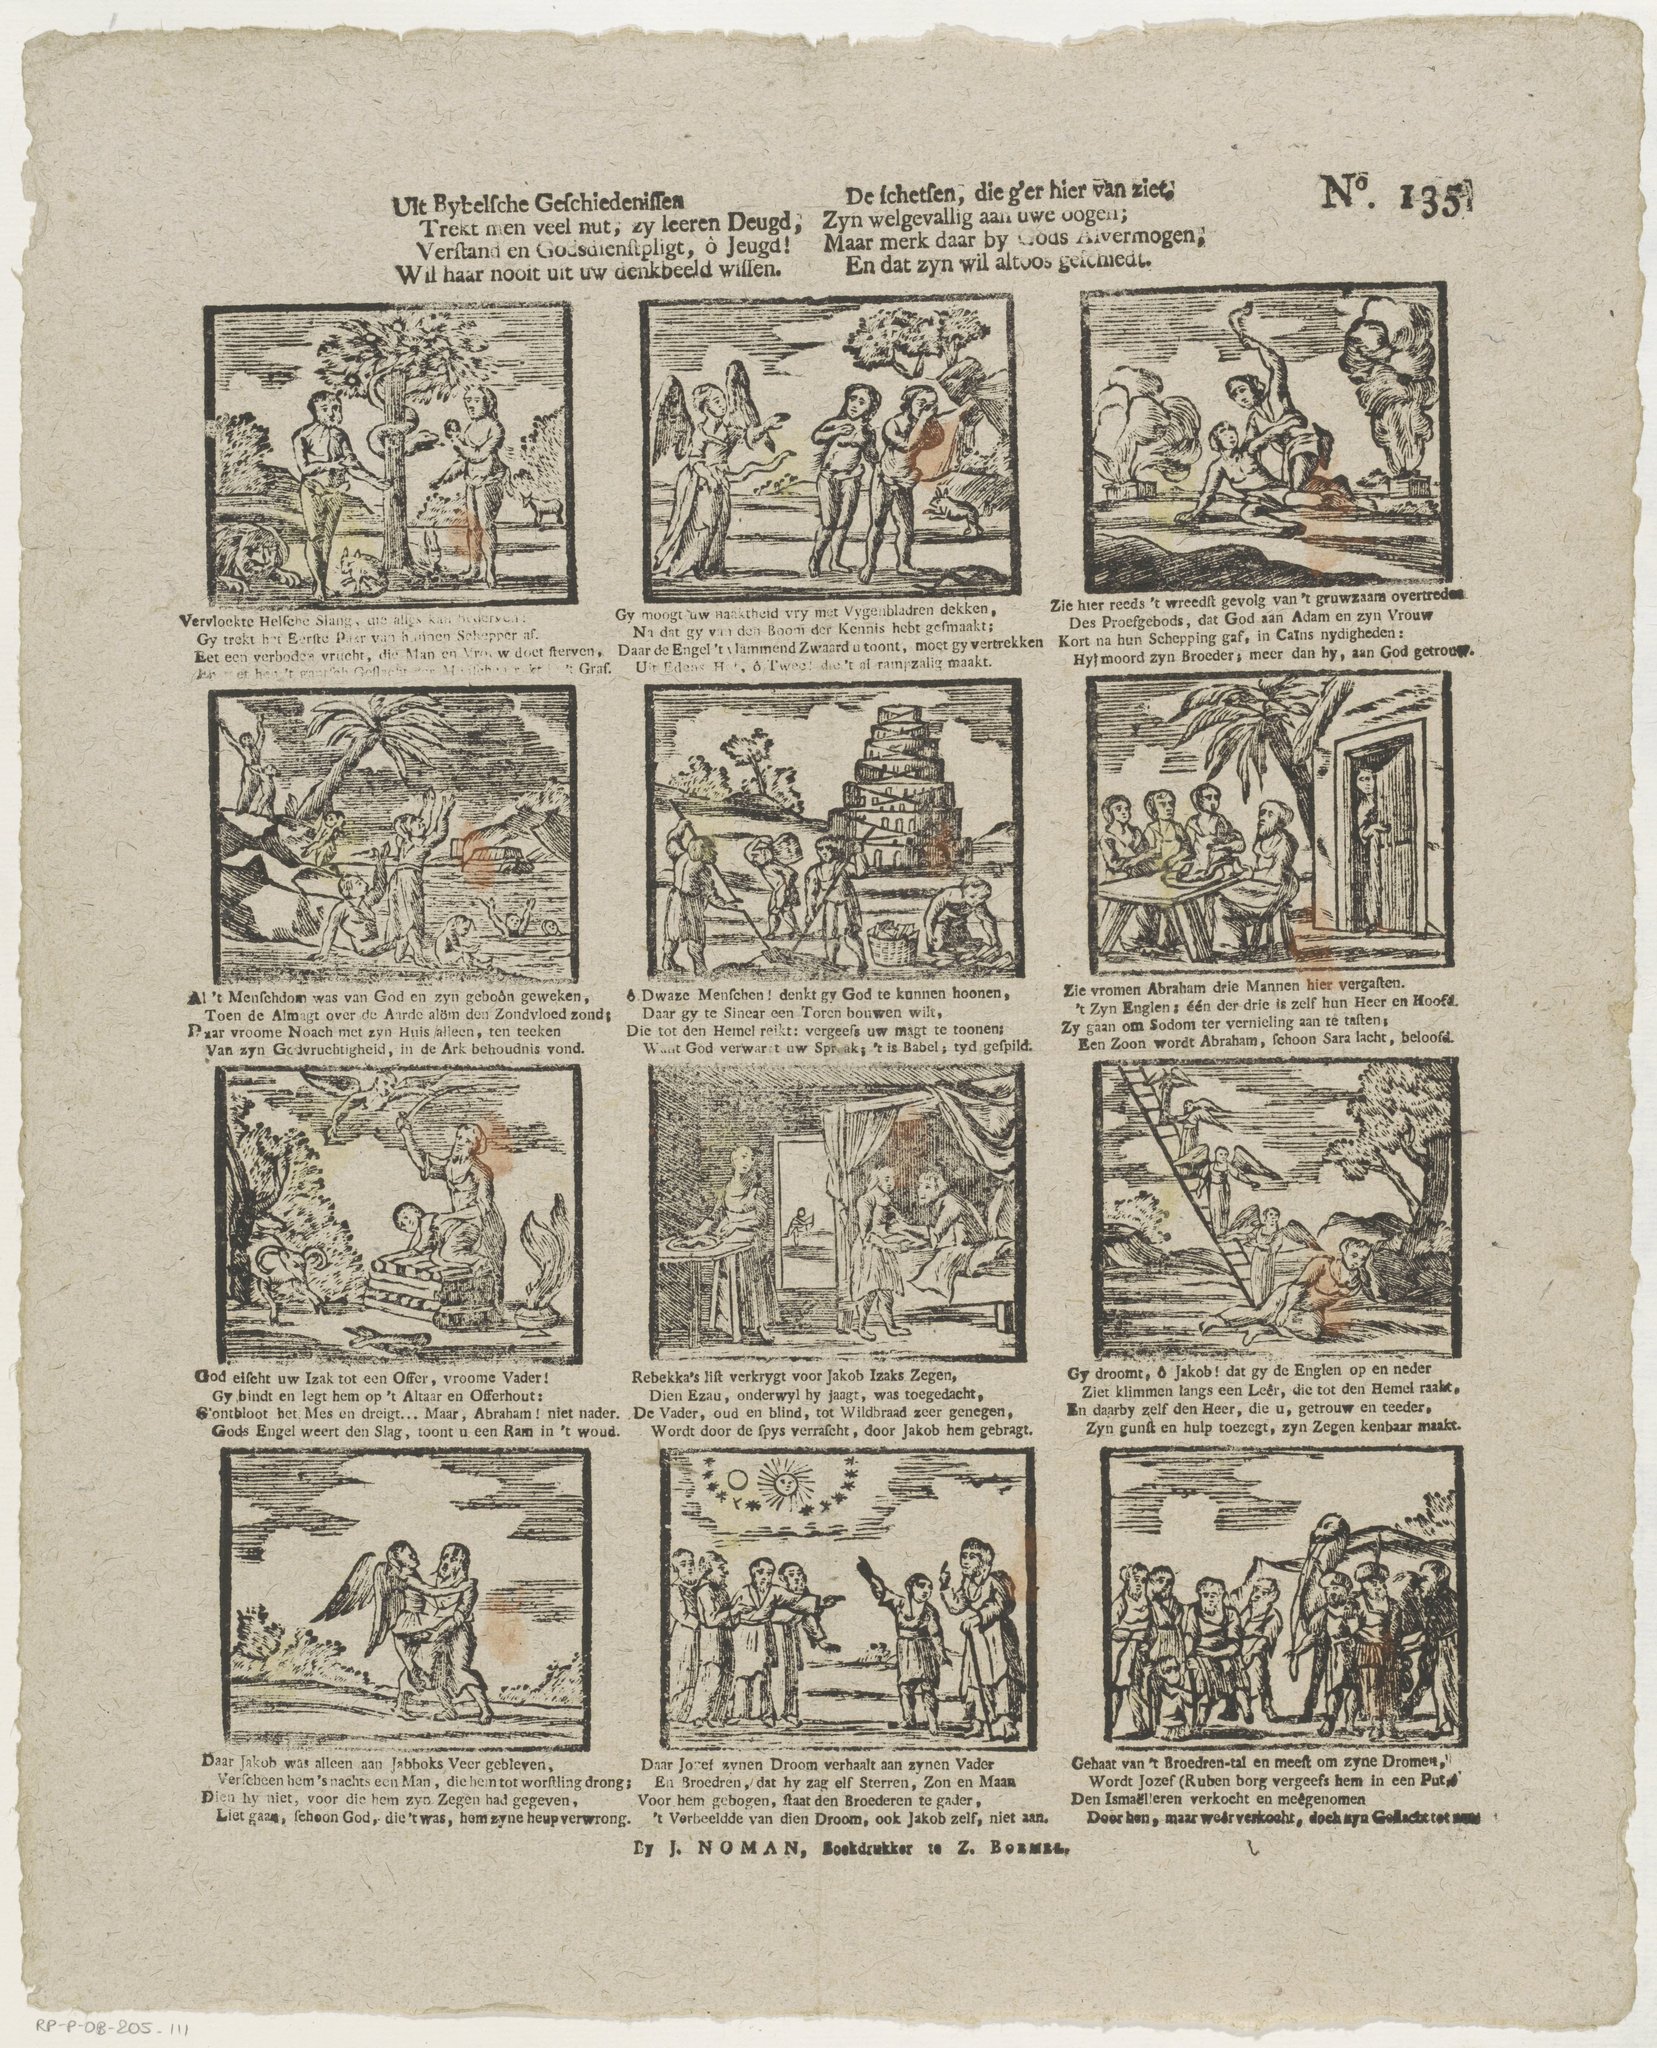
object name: print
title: Uit Bybelsche geschiedenissen / Trekt men veel nut; zy leeren deugd [(...)]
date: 1806-1830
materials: paper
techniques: colour, letterpress printing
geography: zaltbommel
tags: expulsion of adam and eve from paradise (genesis 3:22-24), story of jacob, old testament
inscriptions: collector's mark: Lugt 2760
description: Blad met 12 voorstellingen van verhalen uit het Oude Testament, zoals de verdrijving van Adam en Eva uit het paradijs en de dood van Abel. Onder elke afbeelding een vierregelig vers. Genummerd rechtsboven: No. 135.